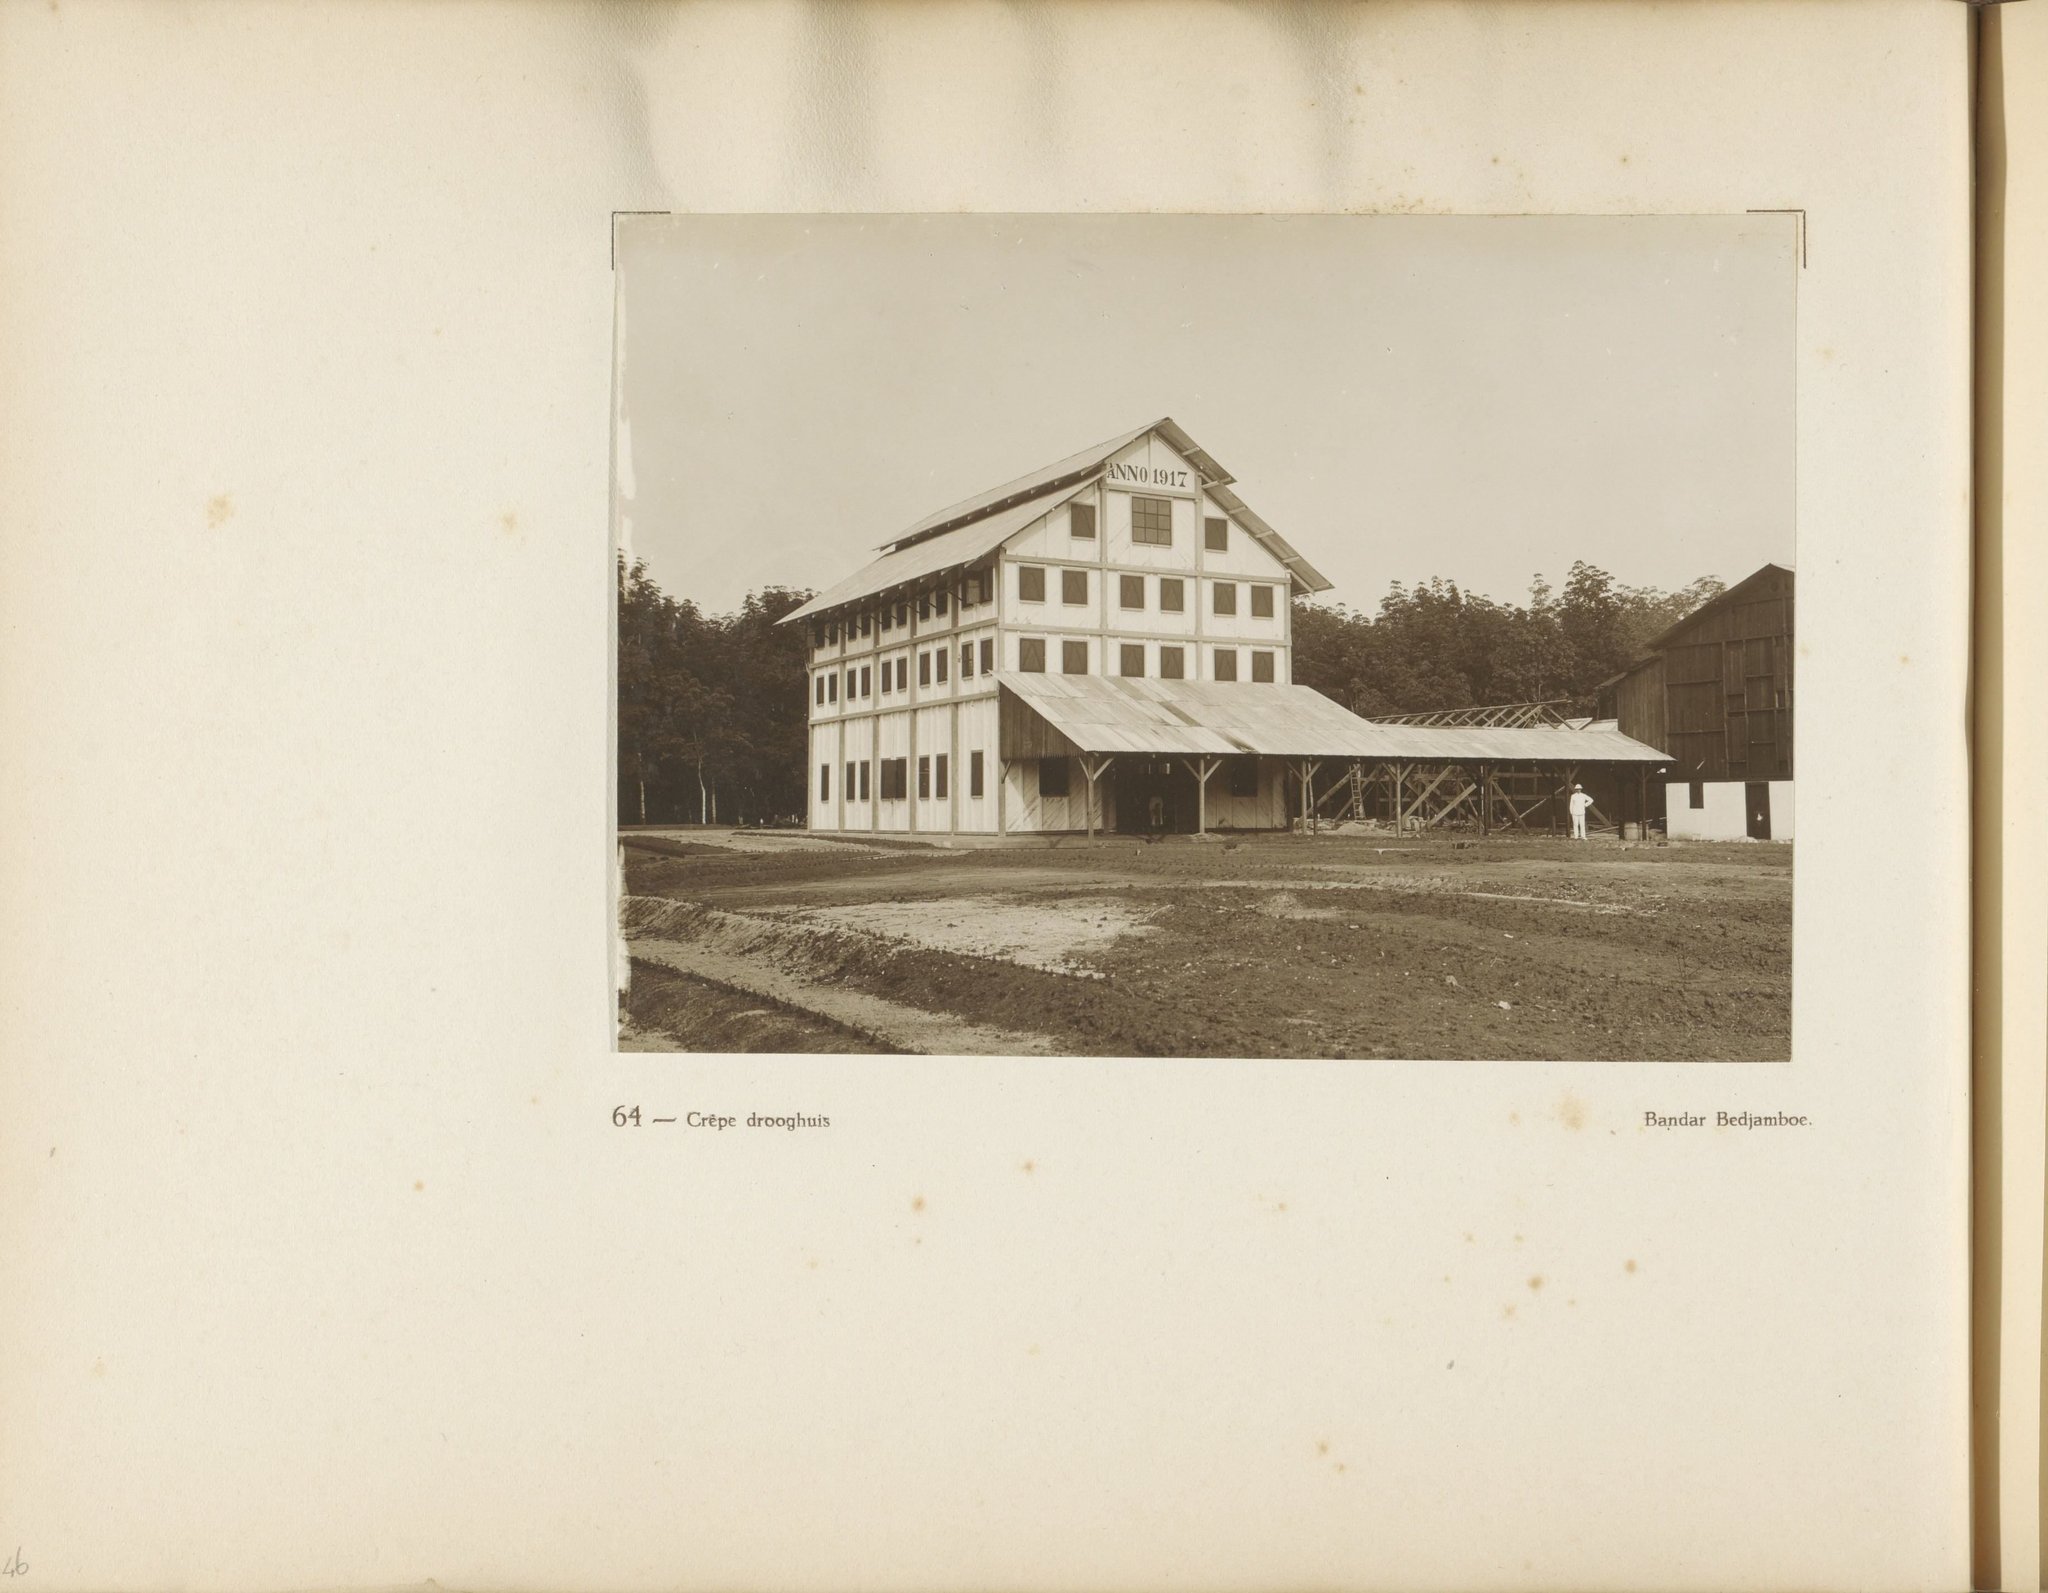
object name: album leaf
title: Pagina 64 van fotoboek van de Algemeene Vereeniging van Rubberplanters ter Oostkust van Sumatra (A.V.R.O.S.)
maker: j.w. meyster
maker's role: fotograaf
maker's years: 1887-1945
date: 1924-1925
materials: paper, photographic support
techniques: printing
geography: sumatra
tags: factory-building, (non-fruit) products of plants or trees: rubber, sumatra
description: Boekpagina met een foto van het exterieur van een drooghuis voor rubbervellen ('crêpe') van de Algemeene Vereeniging van Rubberplanters ter Oostkust van Sumatra (A.V.R.O.S.) te Bandar Bedjamboe. Onderdeel van een fotoboek van de Algemeene Vereeniging van Rubberplanters ter Oostkust van Sumatra (A.V.R.O.S.).